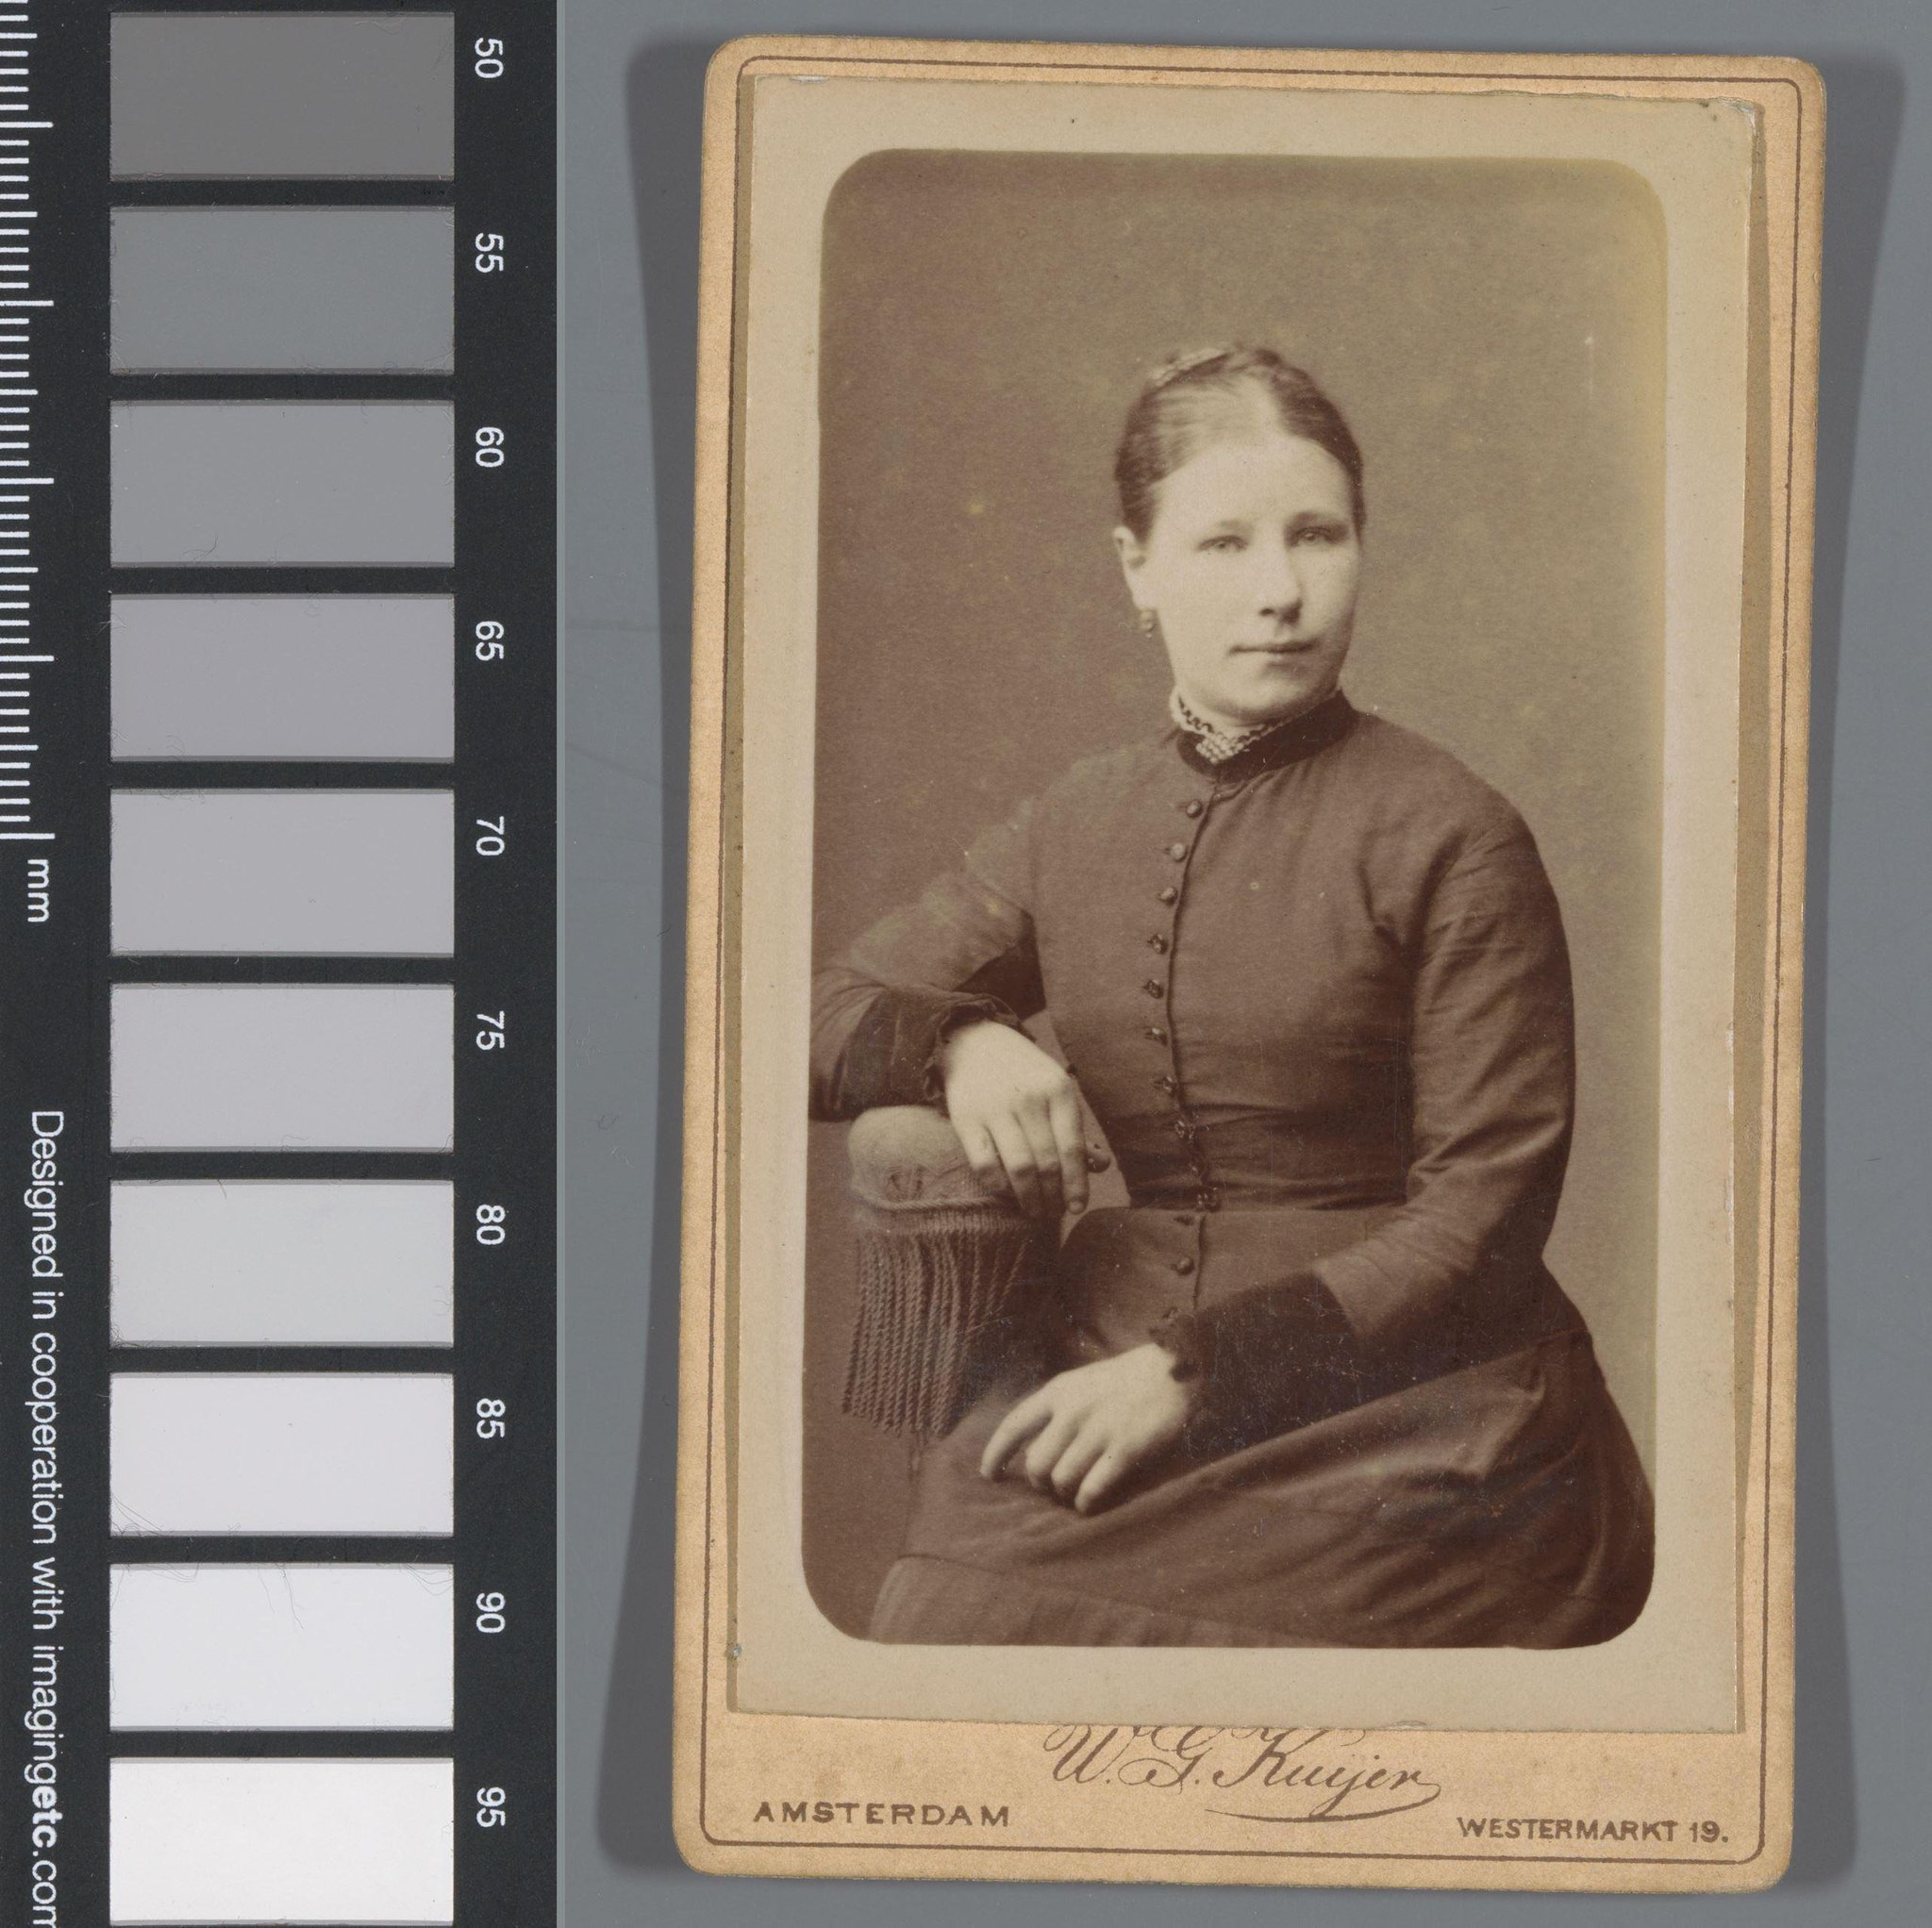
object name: photograph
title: Portret van een onbekende zittende vrouw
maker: willem gerhardus kuijer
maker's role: fotograaf, hoffotograaf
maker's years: 1834-1899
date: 1880-1906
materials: cardboard, celluloid, paper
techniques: albumen print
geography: amsterdam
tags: adult woman, anonymous historical person portrayed, amsterdam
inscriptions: inscription: ‘W.G. Kuijer/ Amsterdam/ Westermarkt 19.’, inscription: ‘W.G. Kuijer/ Westermarkt 19,/ Amsterdam.’